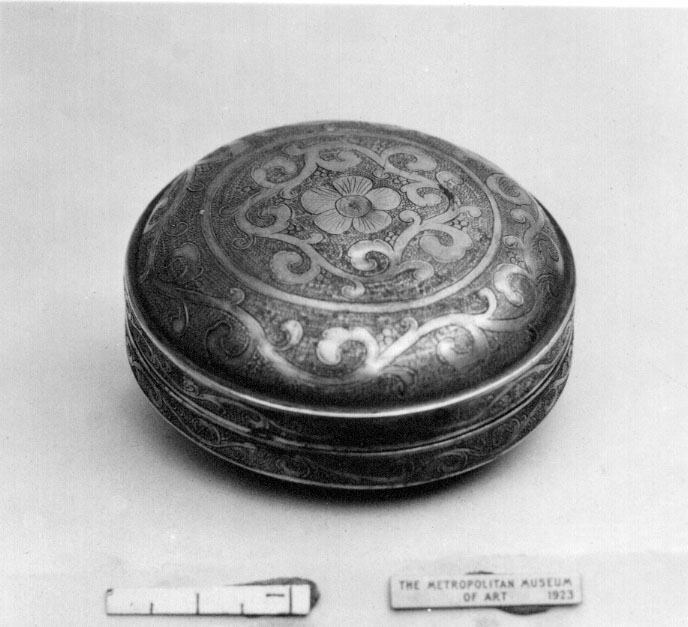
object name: box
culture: chinese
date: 618-907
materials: silver